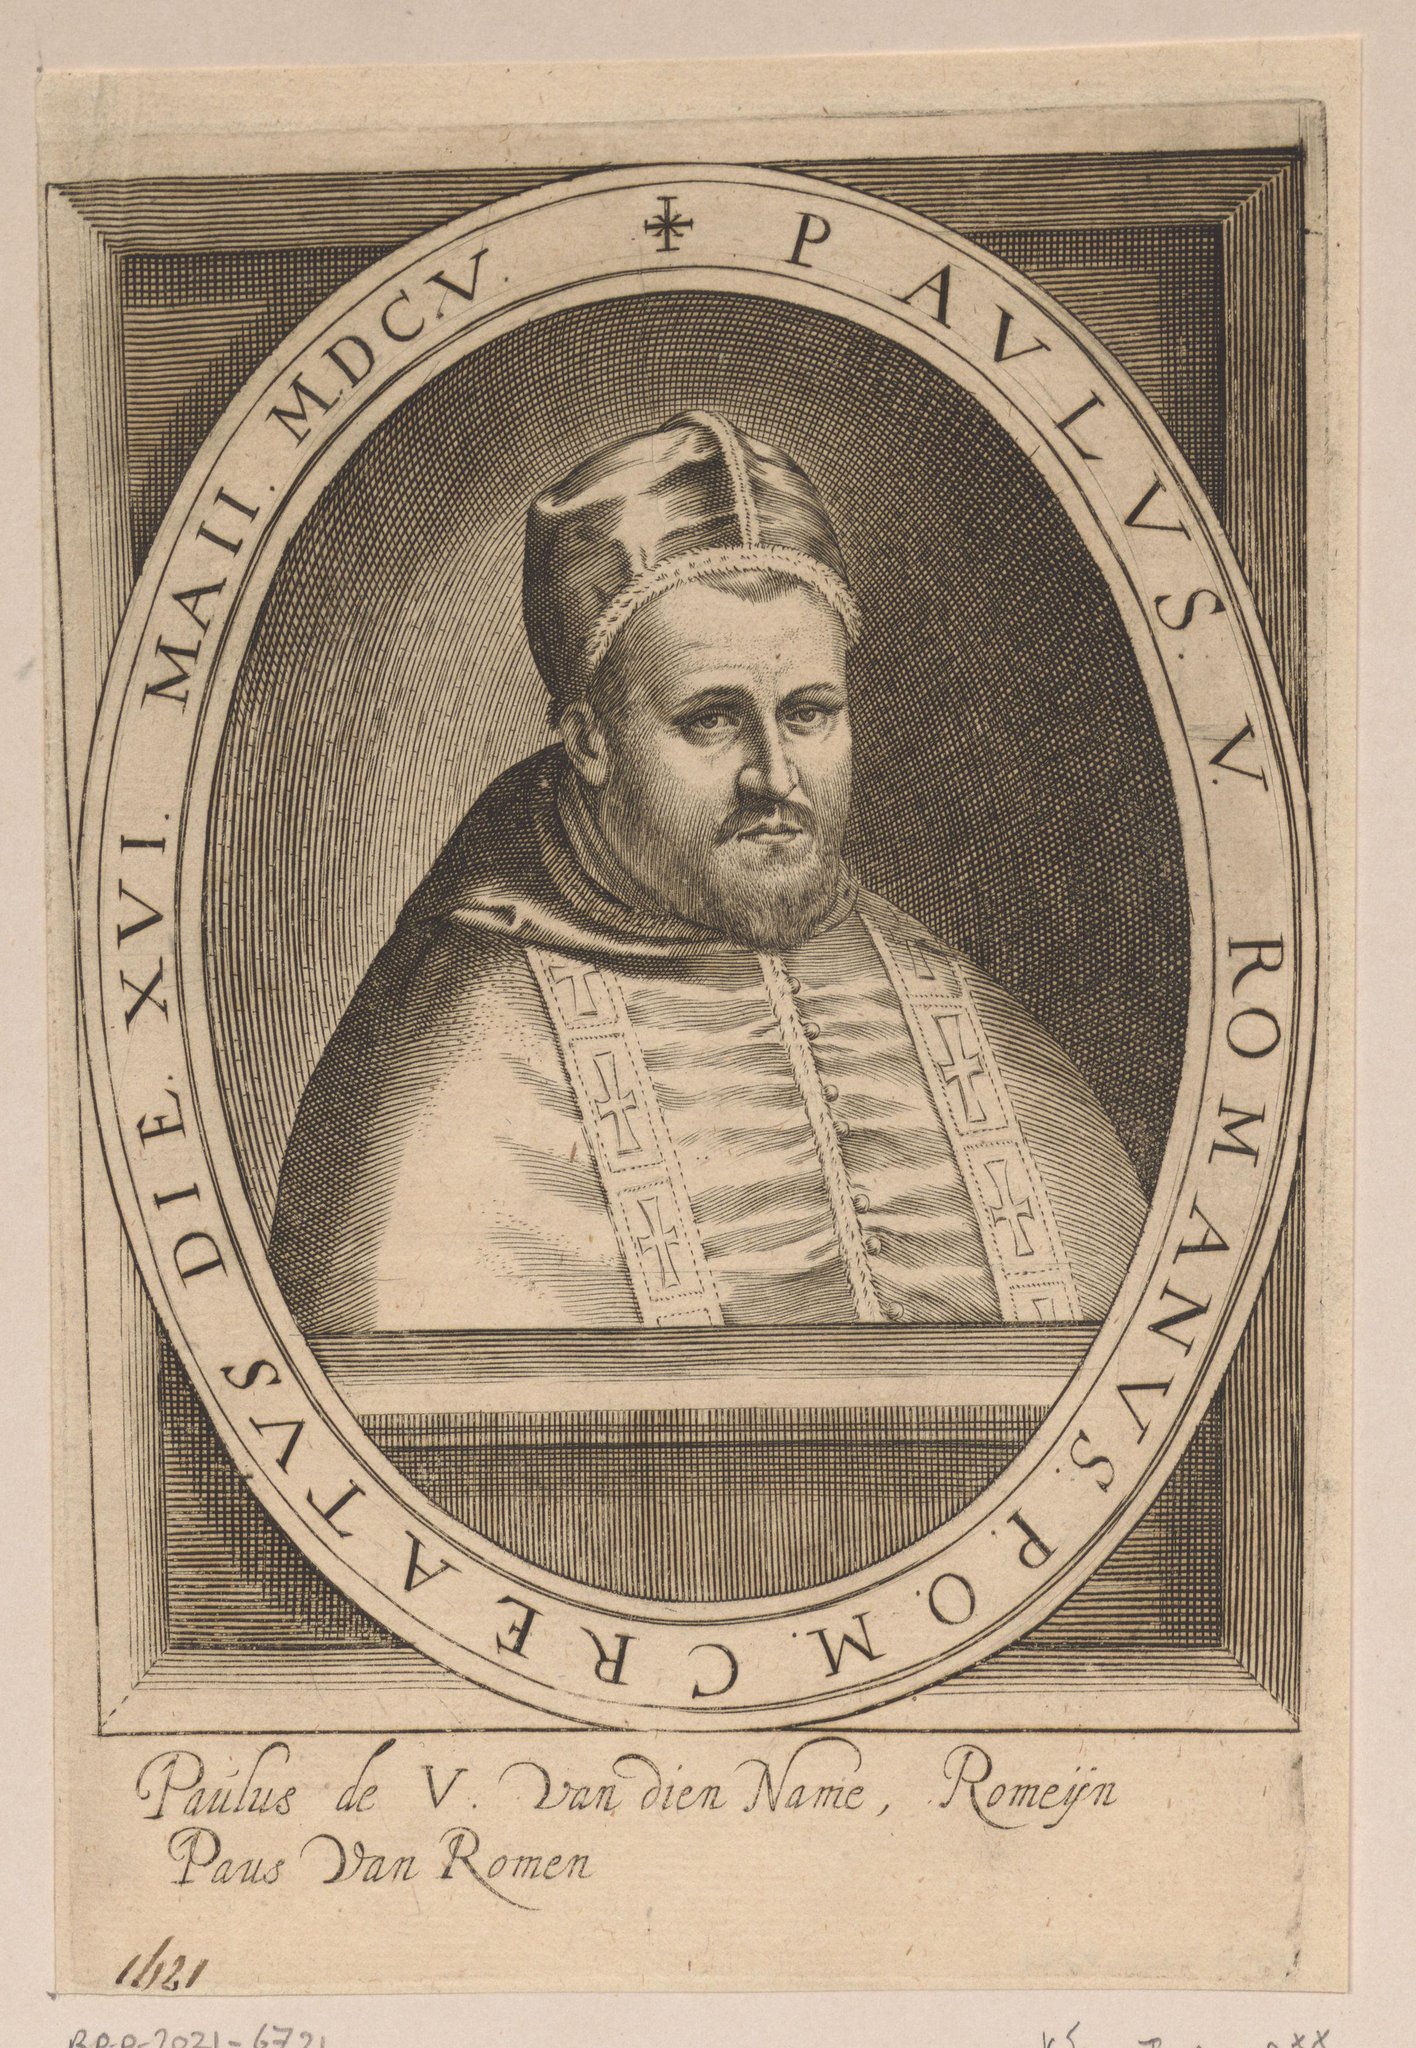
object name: print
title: Portret van paus Paulus V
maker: Anonymous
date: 1605-1699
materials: paper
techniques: engraving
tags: paulus v, adult man, historical persons, pope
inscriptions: inscription: ‘1621’